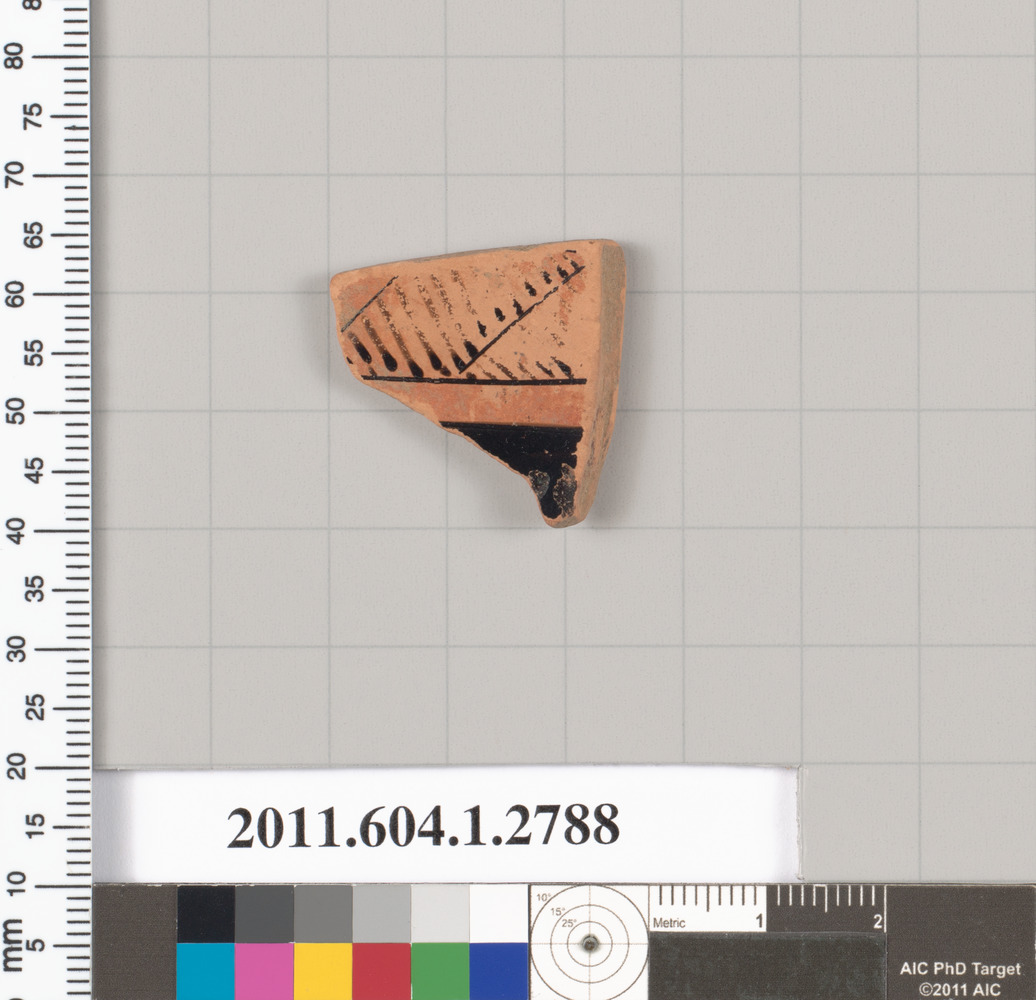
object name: kylix fragment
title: Terracotta fragment of a kylix (drinking cup)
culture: greek, attic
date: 475-451 BCE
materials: terracotta